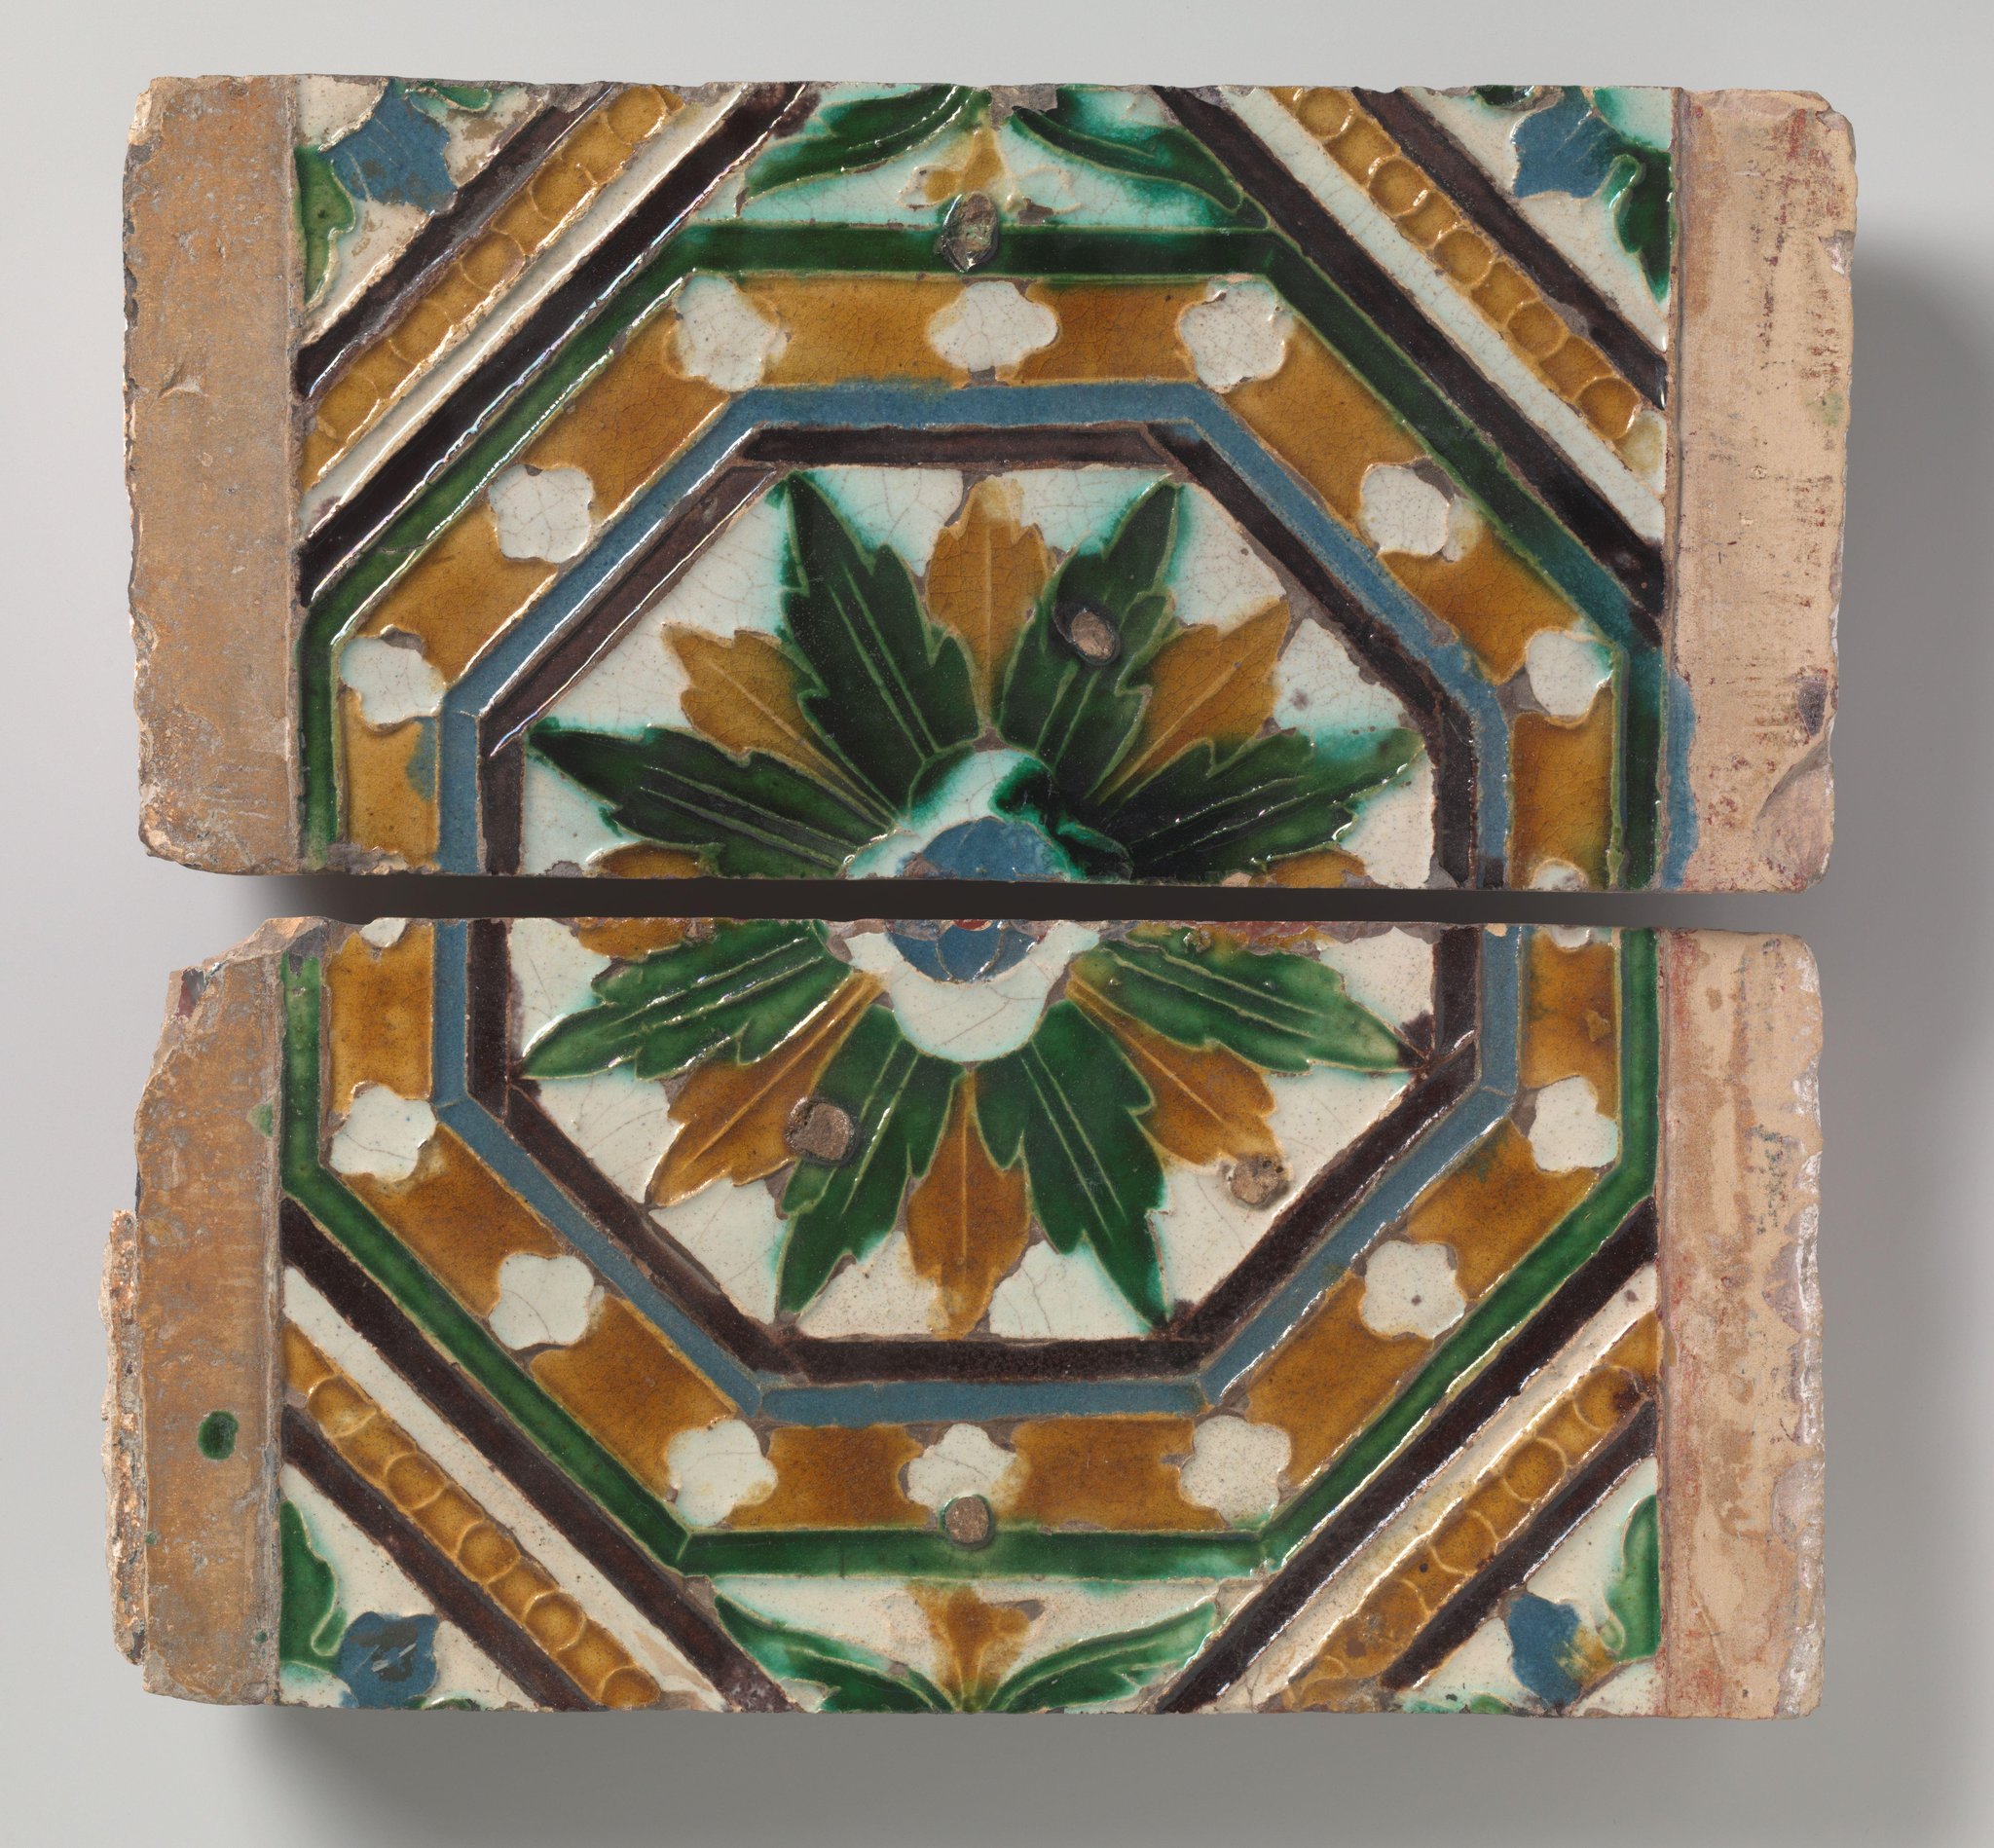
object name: plafondtegel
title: Cuenca-plafondtegel, twee stuks, met centraal achthoekig medaillon met bladrozet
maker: Anonymous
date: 1500-1550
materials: earthenware, glaze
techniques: lace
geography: sevilla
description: Twee bij elkaar horende cuenca-plafondtegels, beschilderd in wit (fond), okergeel, donkergroen, mangaan en lichtblauw. Aan de korte zijden ongeglazuurd. Een brede band vormt een centraal achthoekig medaillon, in het veld een bladrozet. De hoeken rond het medaillon afgezet met banden met een parellijst. In de hoeken kwart rozetten.